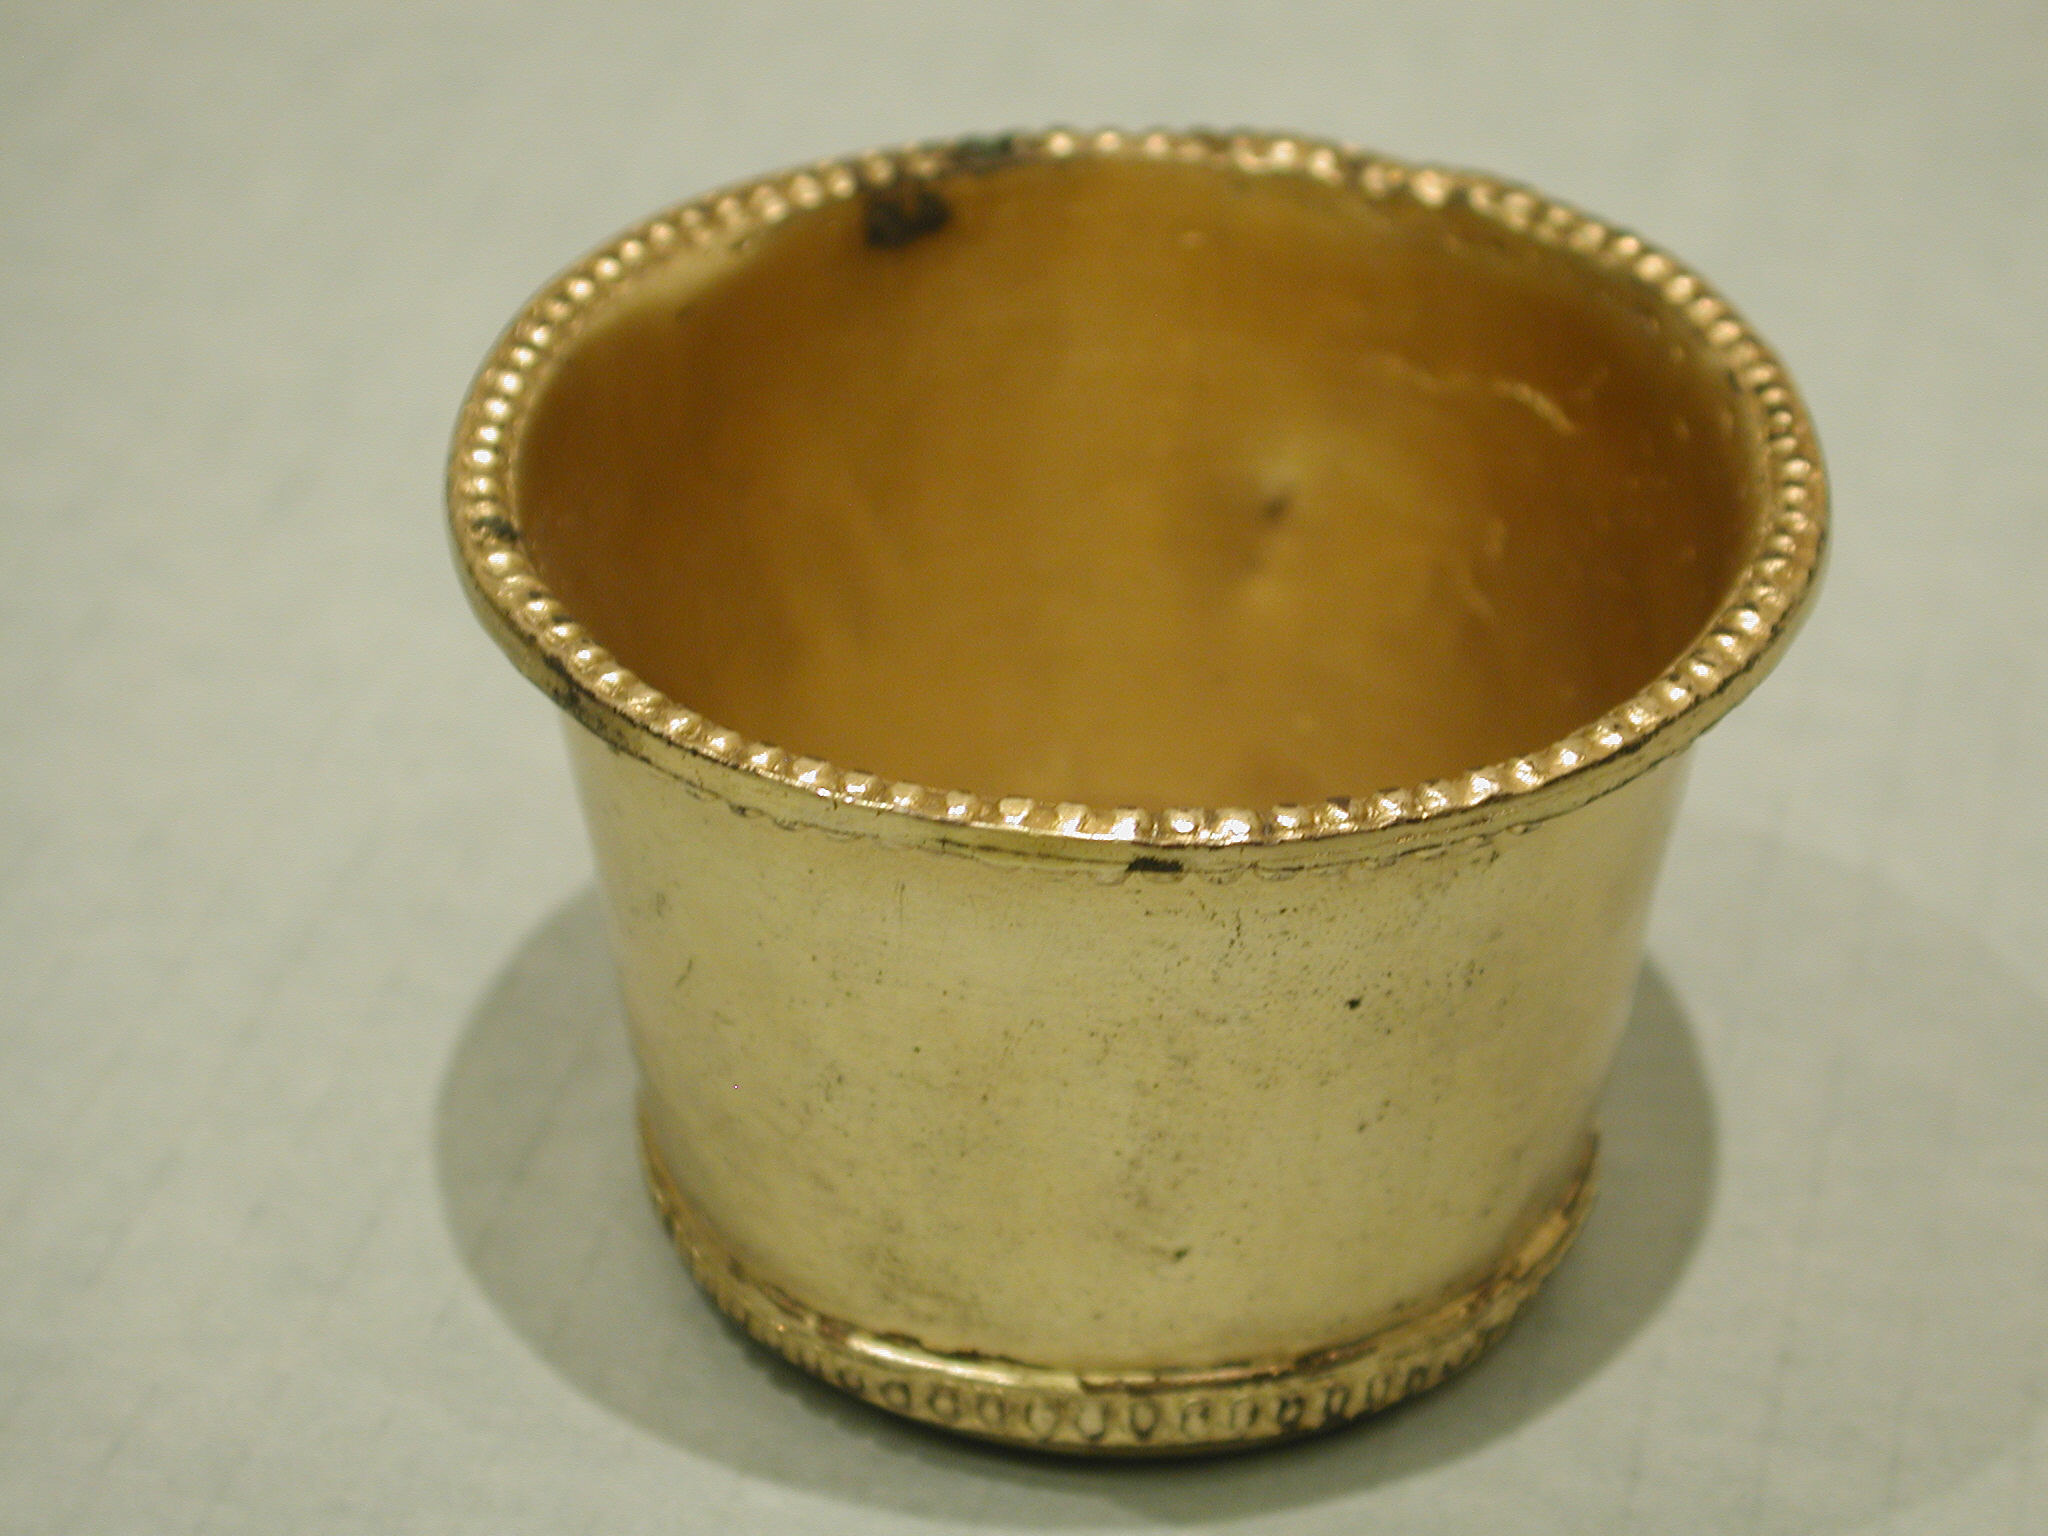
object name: beaker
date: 1801-1900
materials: metal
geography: hungary